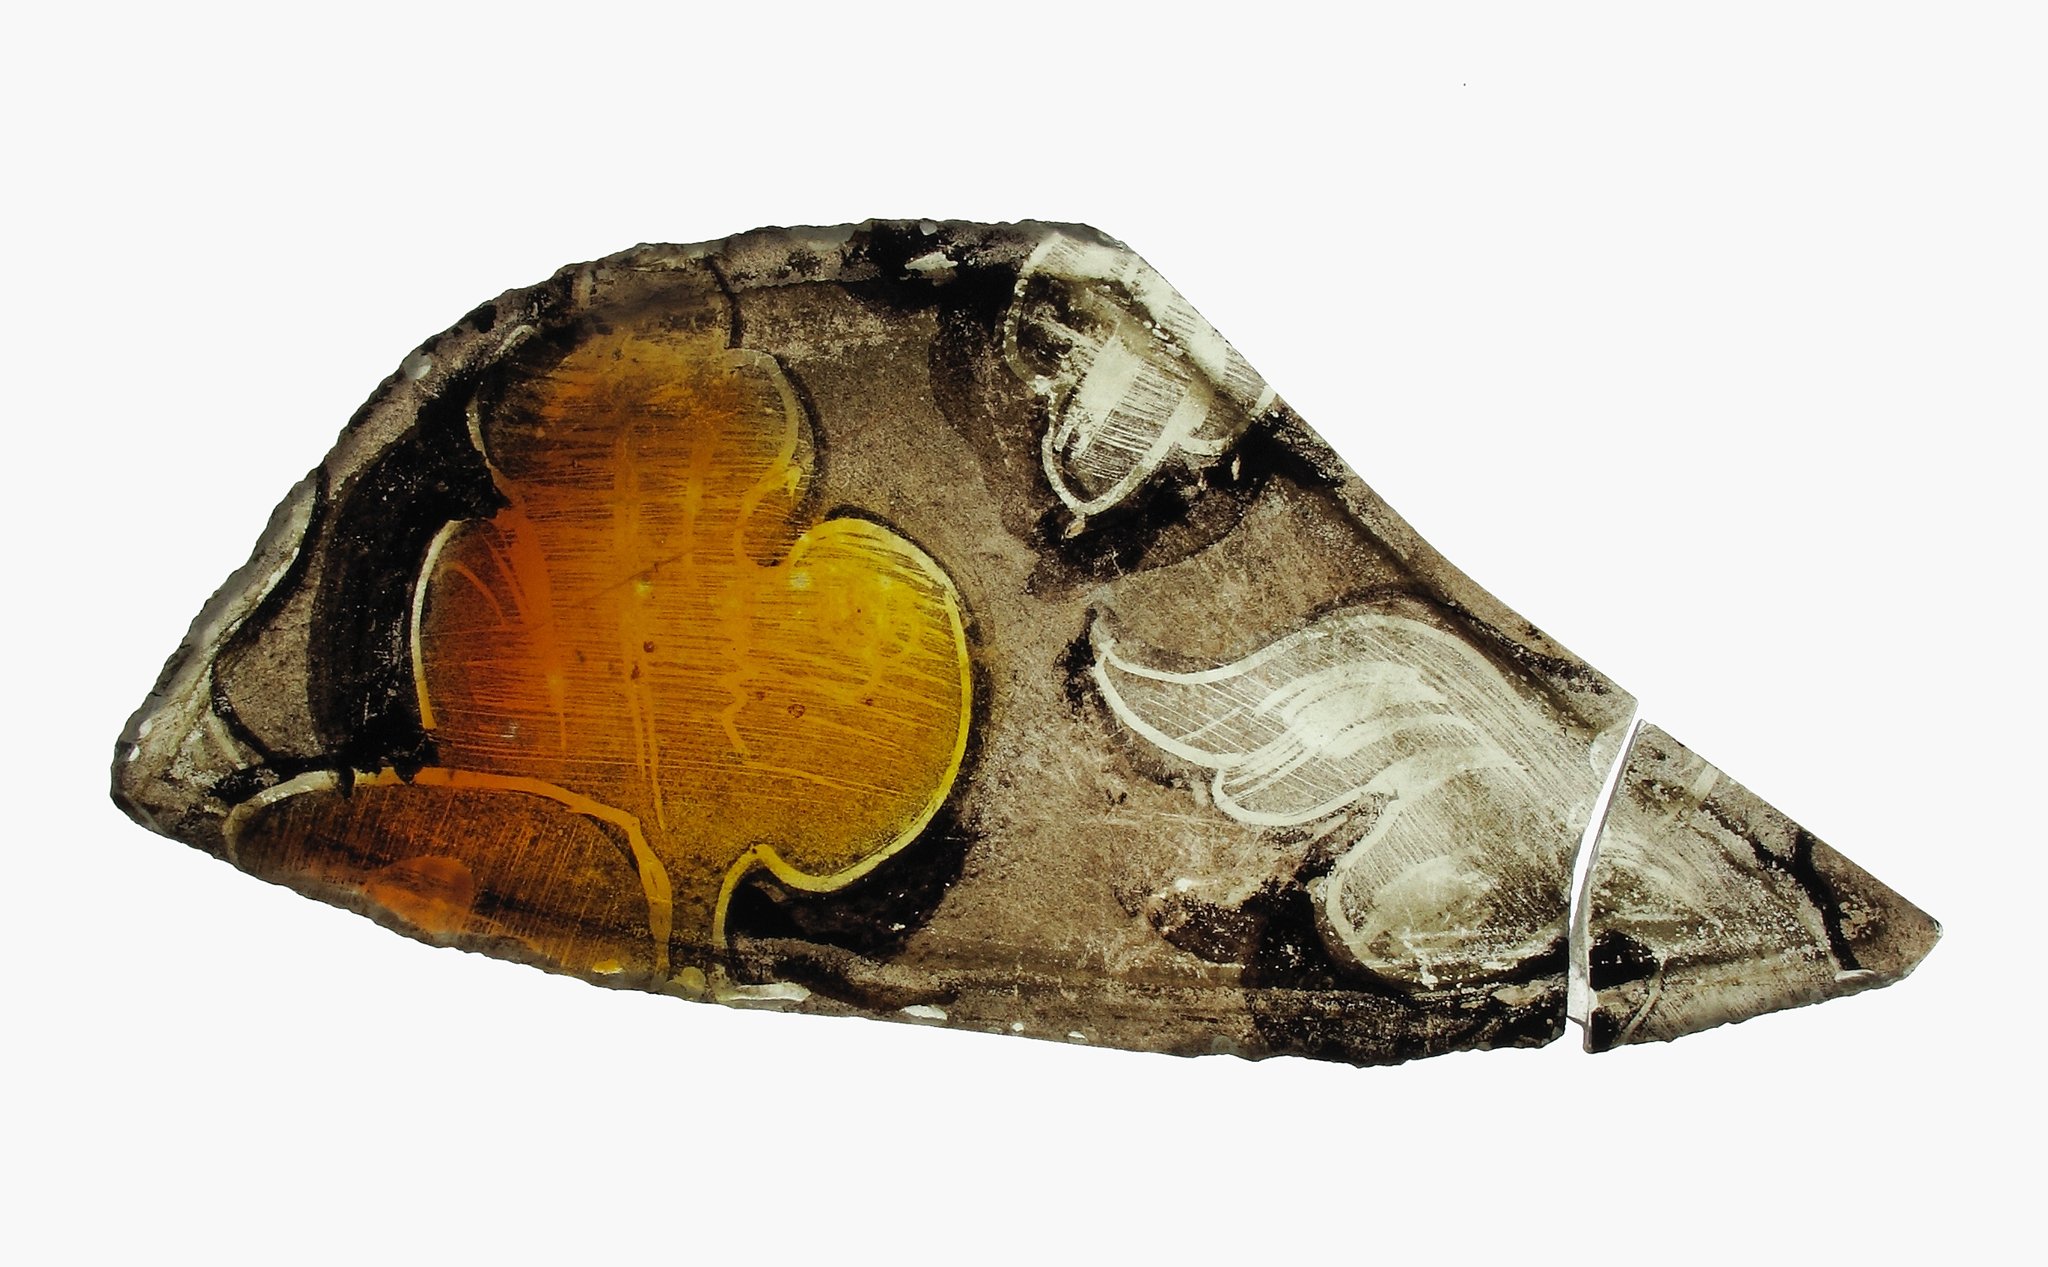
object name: fragment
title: Glass Fragment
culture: german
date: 1601-1700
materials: glass